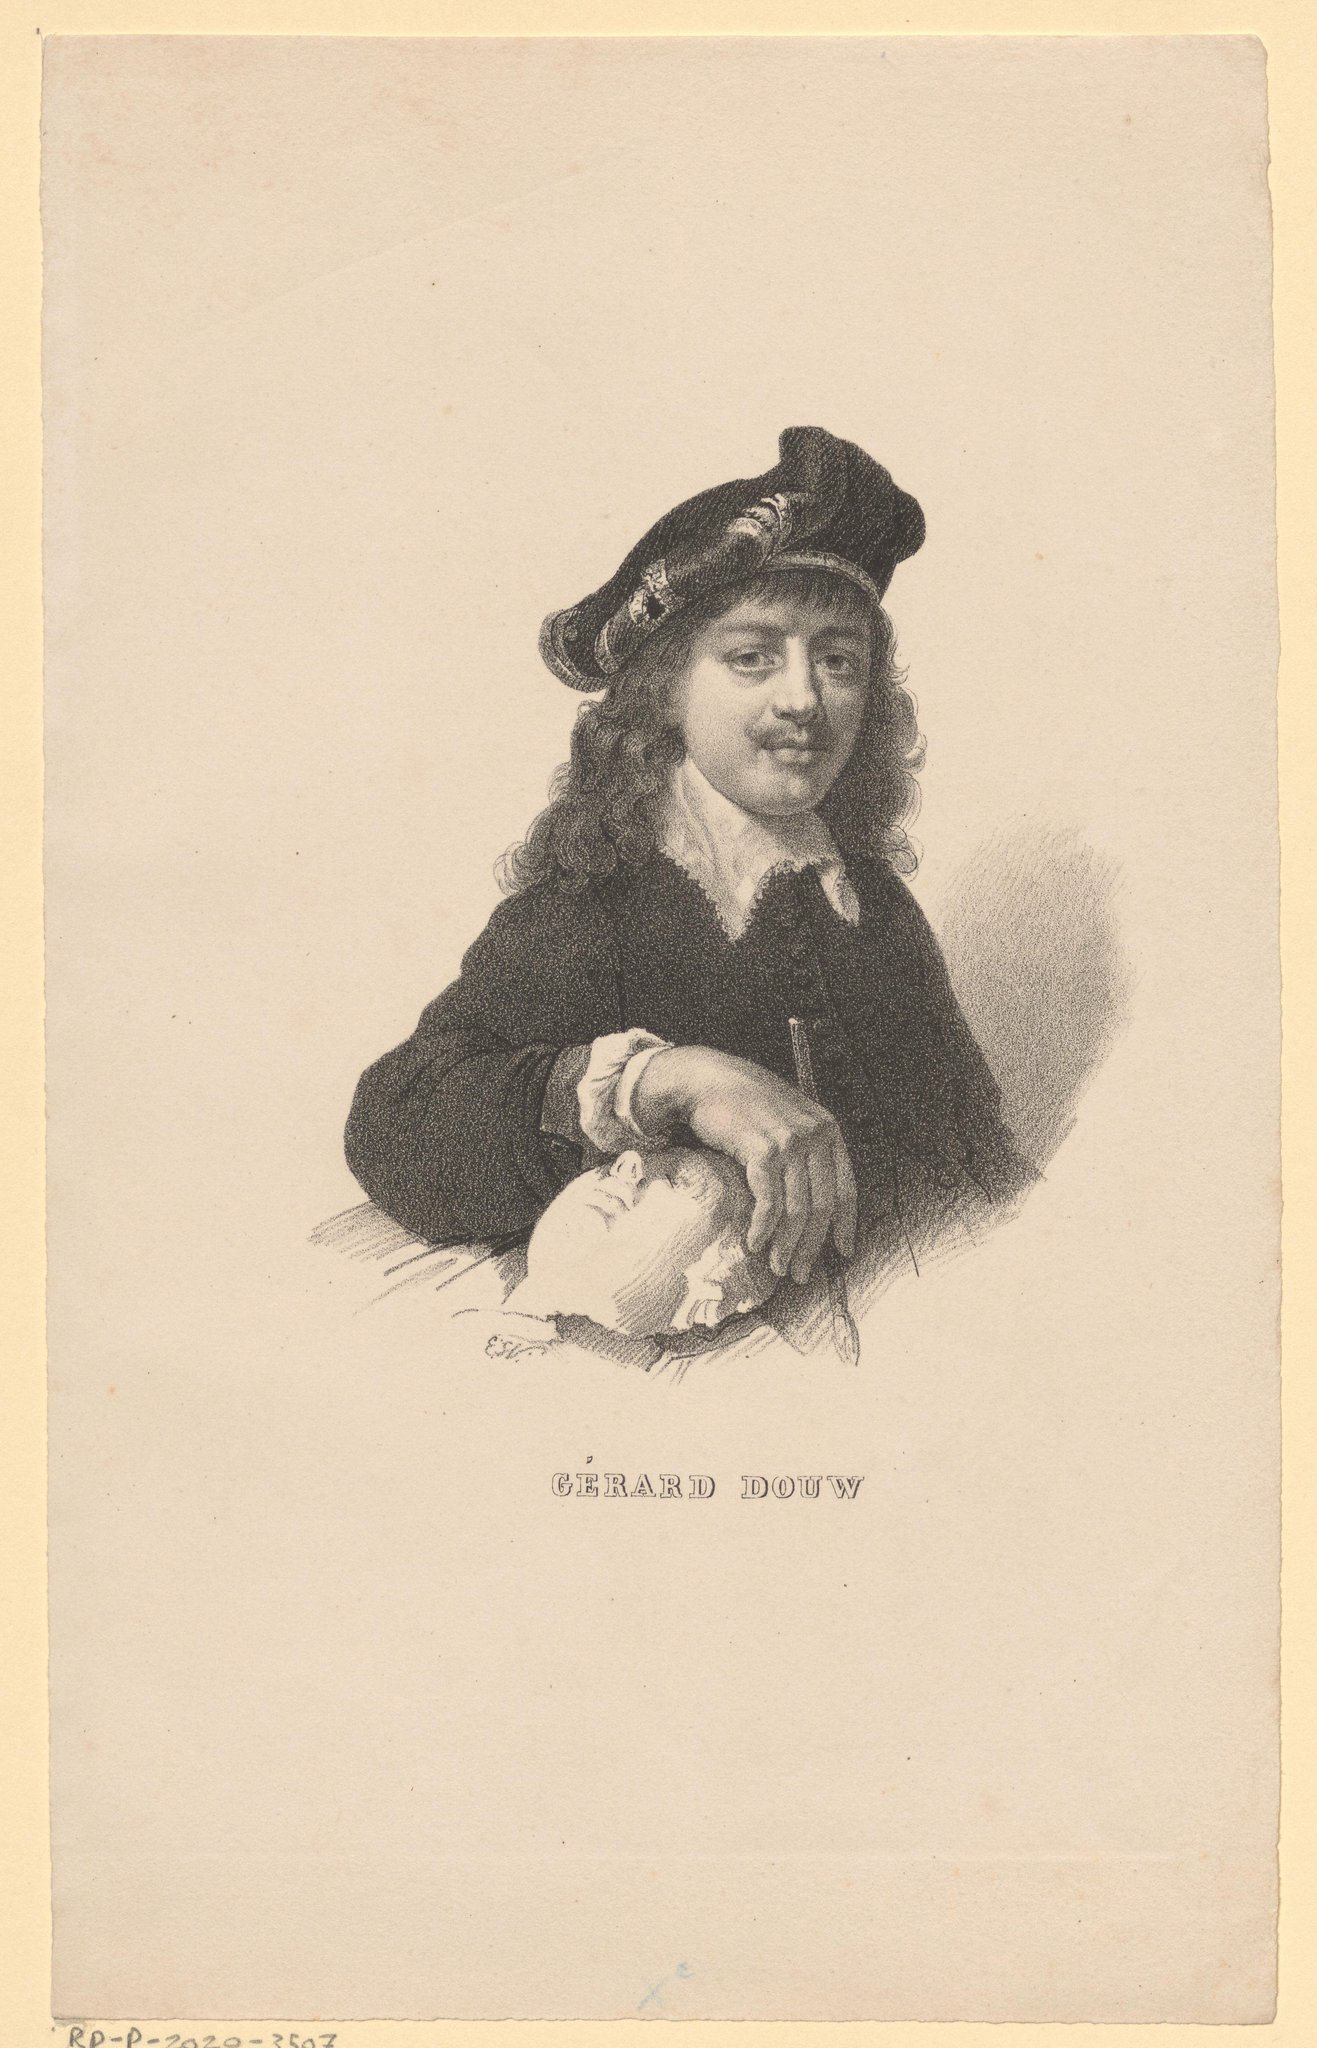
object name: print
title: Portret van Gerard Dou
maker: Anonymous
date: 1810-1899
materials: paper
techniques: lithograph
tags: painter, draughtsman, gerard dou, historical persons, portrait, self-portrait of artist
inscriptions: monogram: ‘E.S.V.’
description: Met een penseel in zijn rechterhand en leunend op het hoofd van een sculptuur.